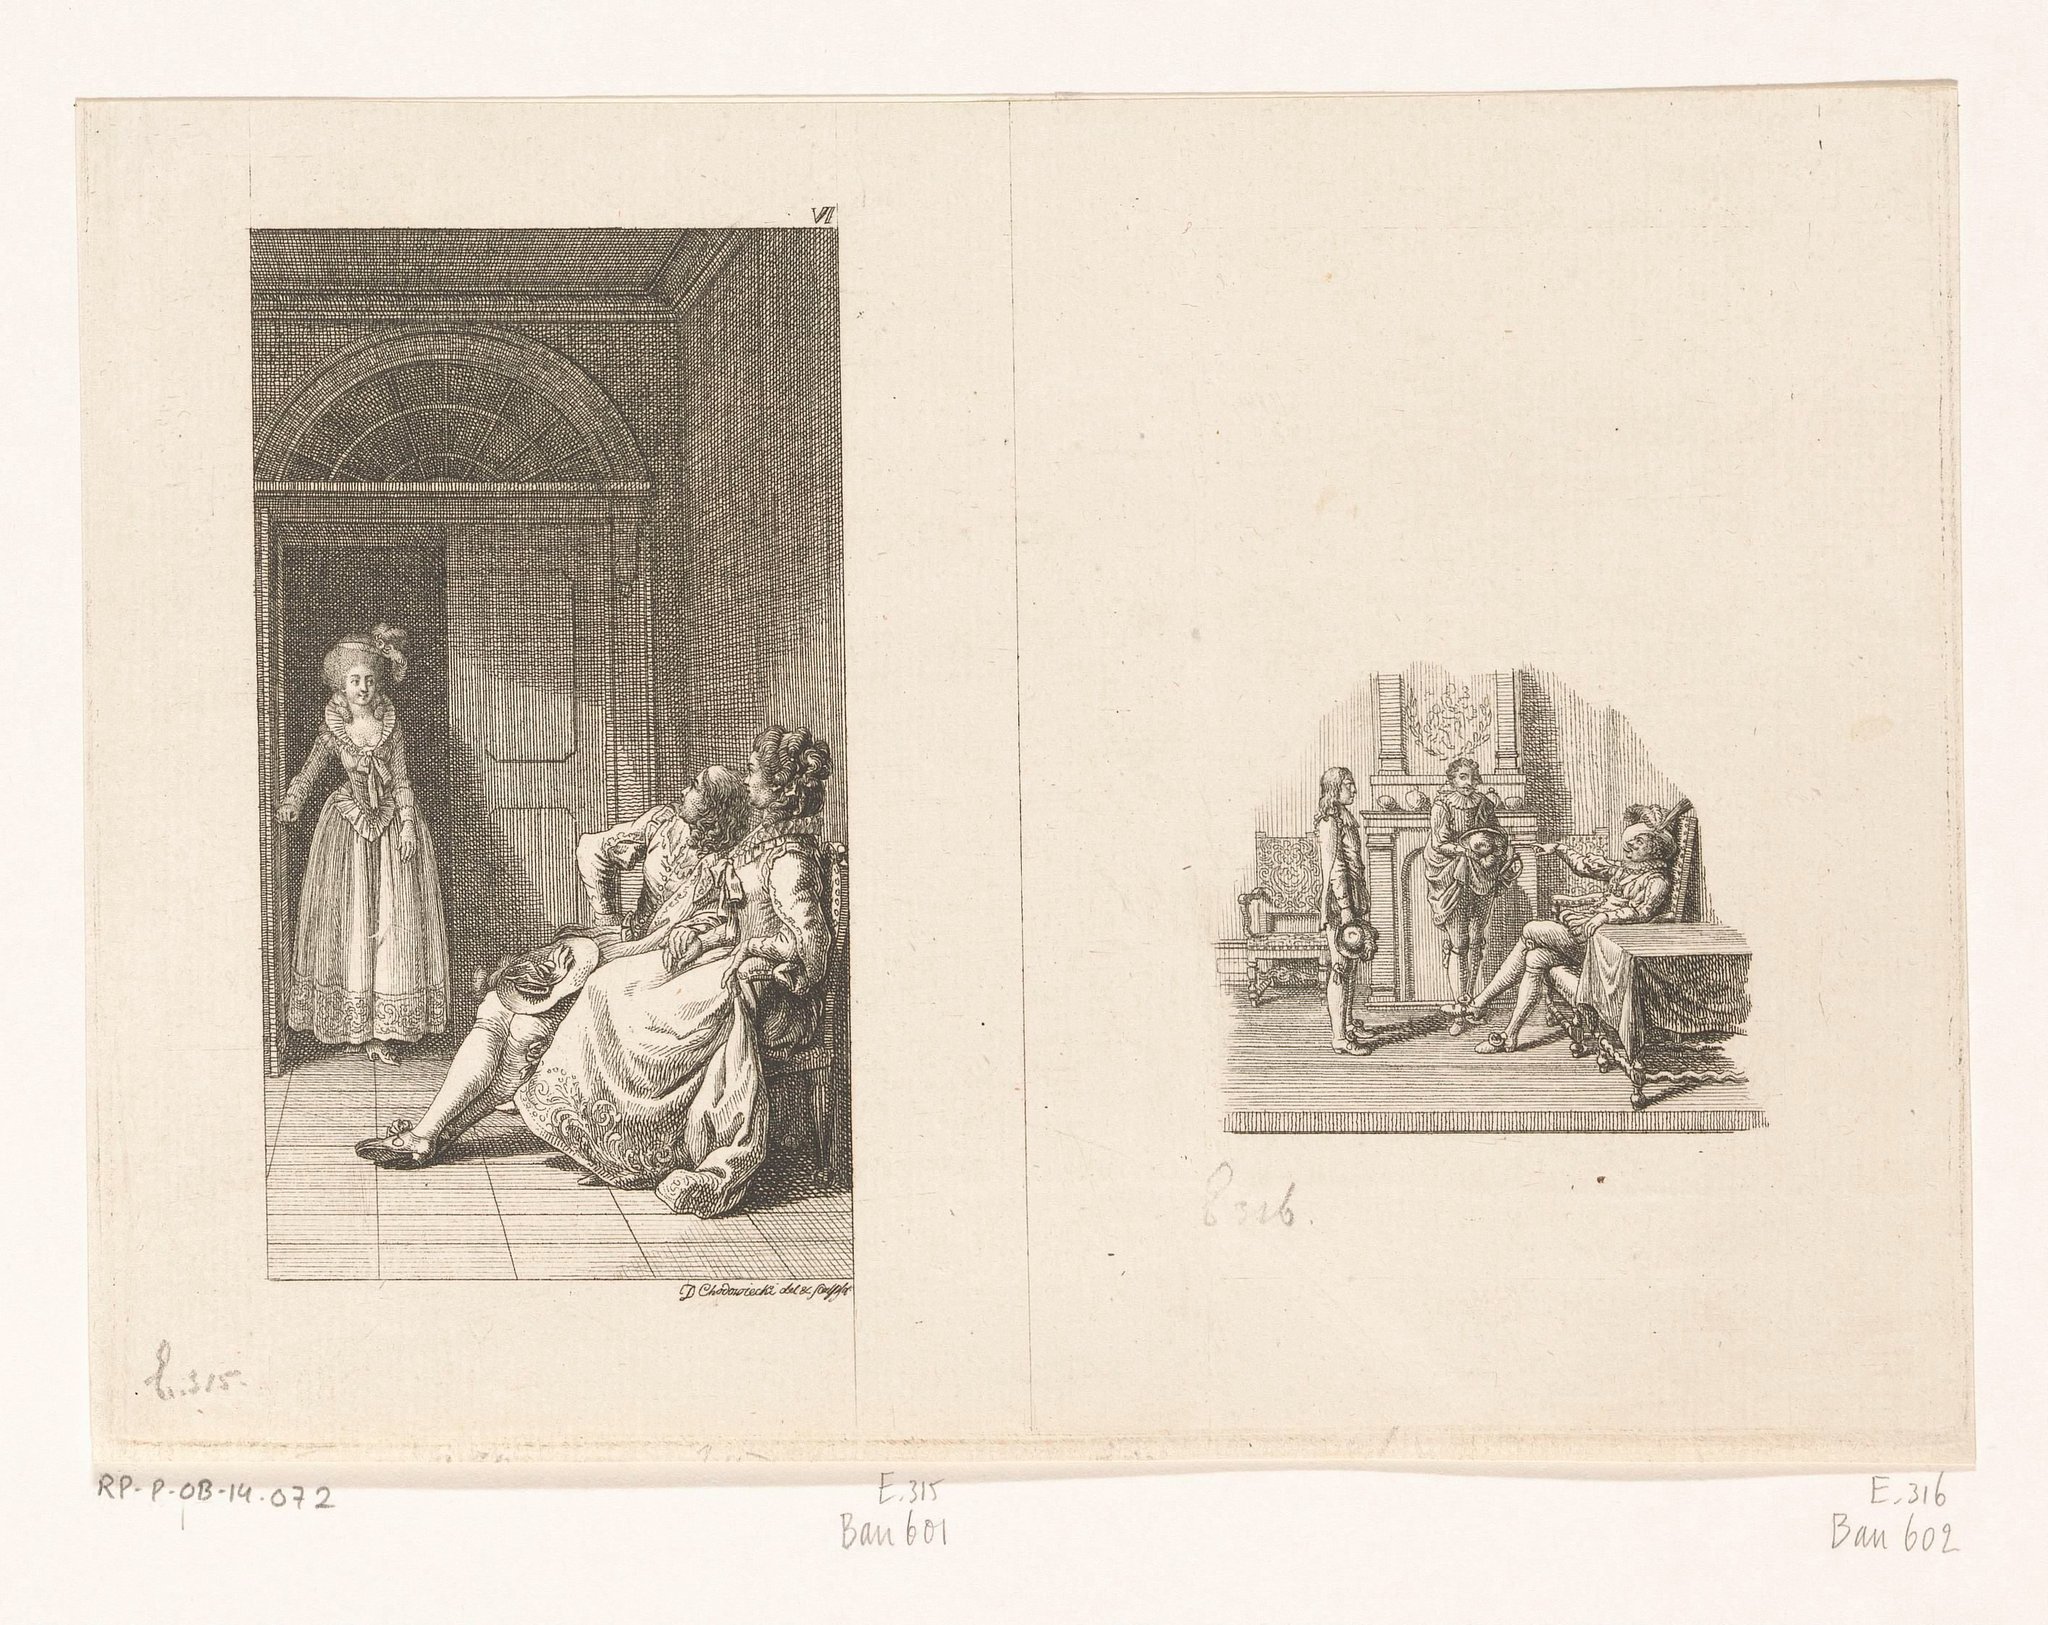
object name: print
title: Gil Blas en Lukrezia en vignet met Gil Blas voor erfprins Filips van Spanje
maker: daniel nikolaus chodowiecki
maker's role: draughtsman, print maker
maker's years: 1726-1801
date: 1779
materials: paper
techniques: etching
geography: berlin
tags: literature, audition; ruler giving audience, conversation, dialogue; conversation piece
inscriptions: collector's mark: Lugt 2228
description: Links bespreekt Gil Blas met Estrella, zijn oude liefde Laura, de toekomst van 'nicht' Lukrezia. Op het moment dat Estrella zich verspreekt en het Gil Blas duidelijk wordt dat Lukrezia eigenlijk zijn dochter is, komt de veertienjarige binnen. Rechts Gil Blas op audiëntie bij erfprins Filips van Spanje (rechts op een leunstoel). De prins beveelt hem aan bij de graaf van Leyra (staand voor de schouw).